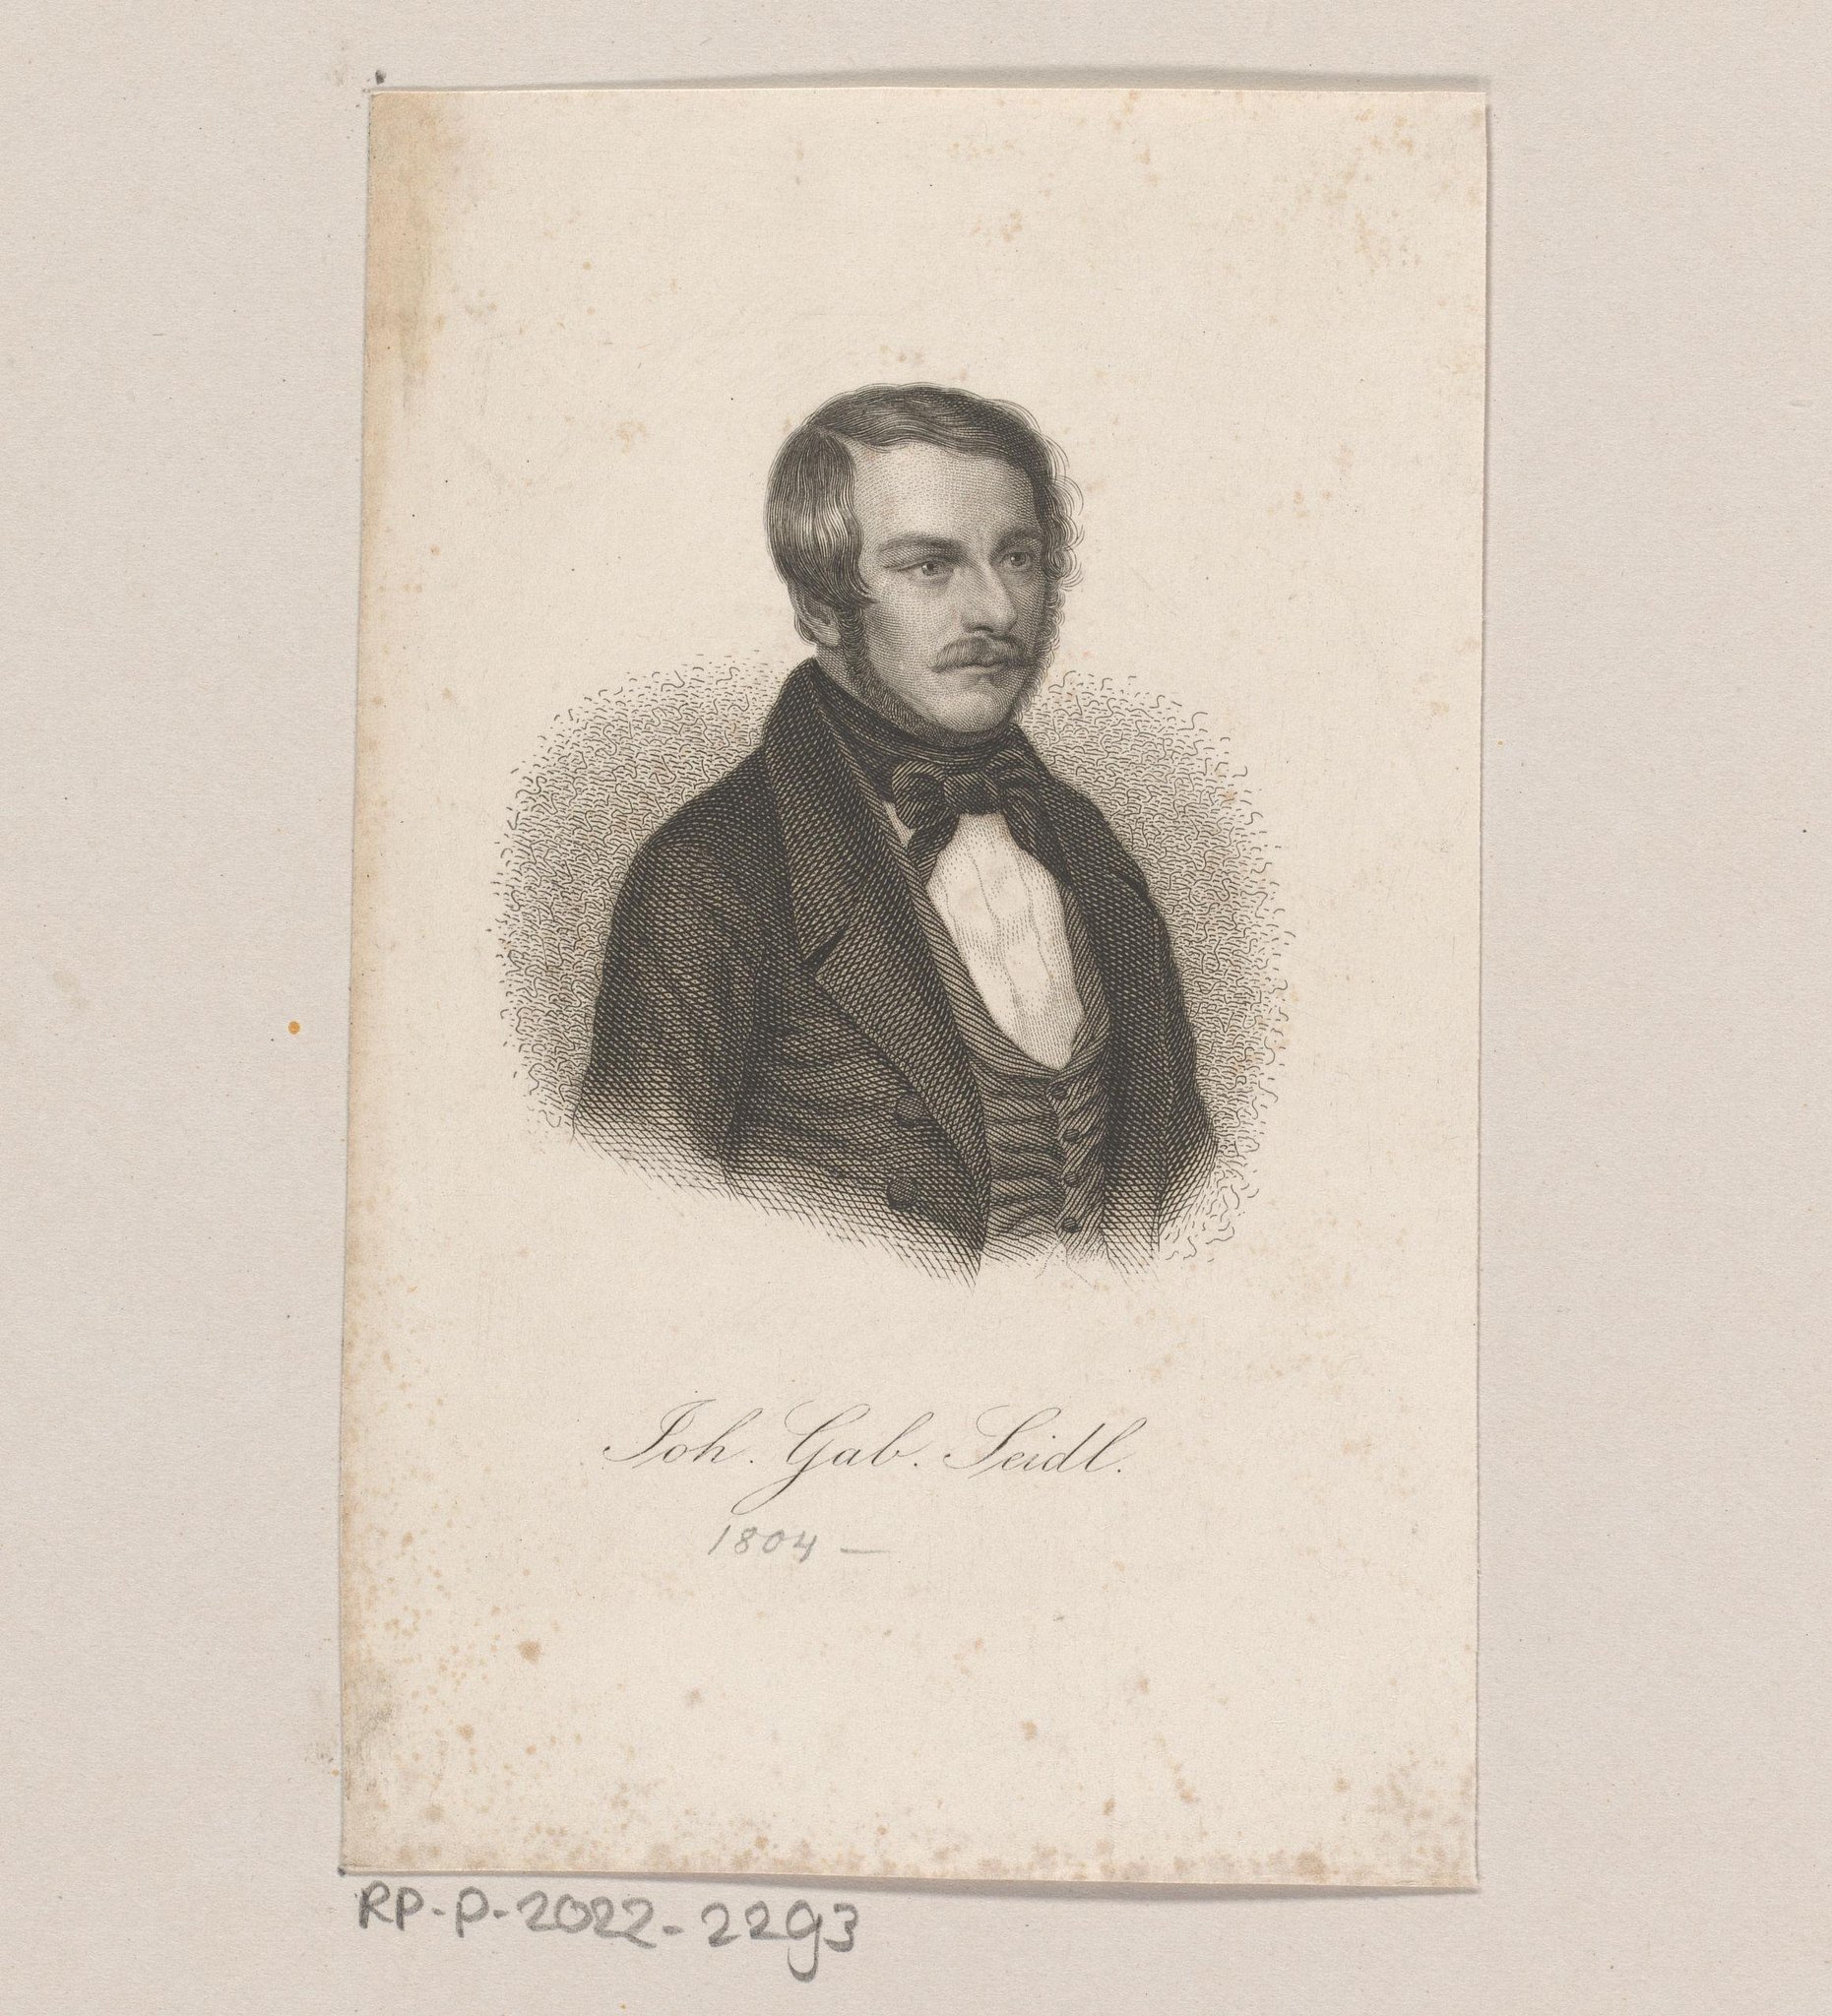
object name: print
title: Portret van Johann Gabriel Seidl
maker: Anonymous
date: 1824-1899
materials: paper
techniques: engraving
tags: vienna, history and archaeology (+ portrait of scholar, scientist), historical persons, portrait of a writer